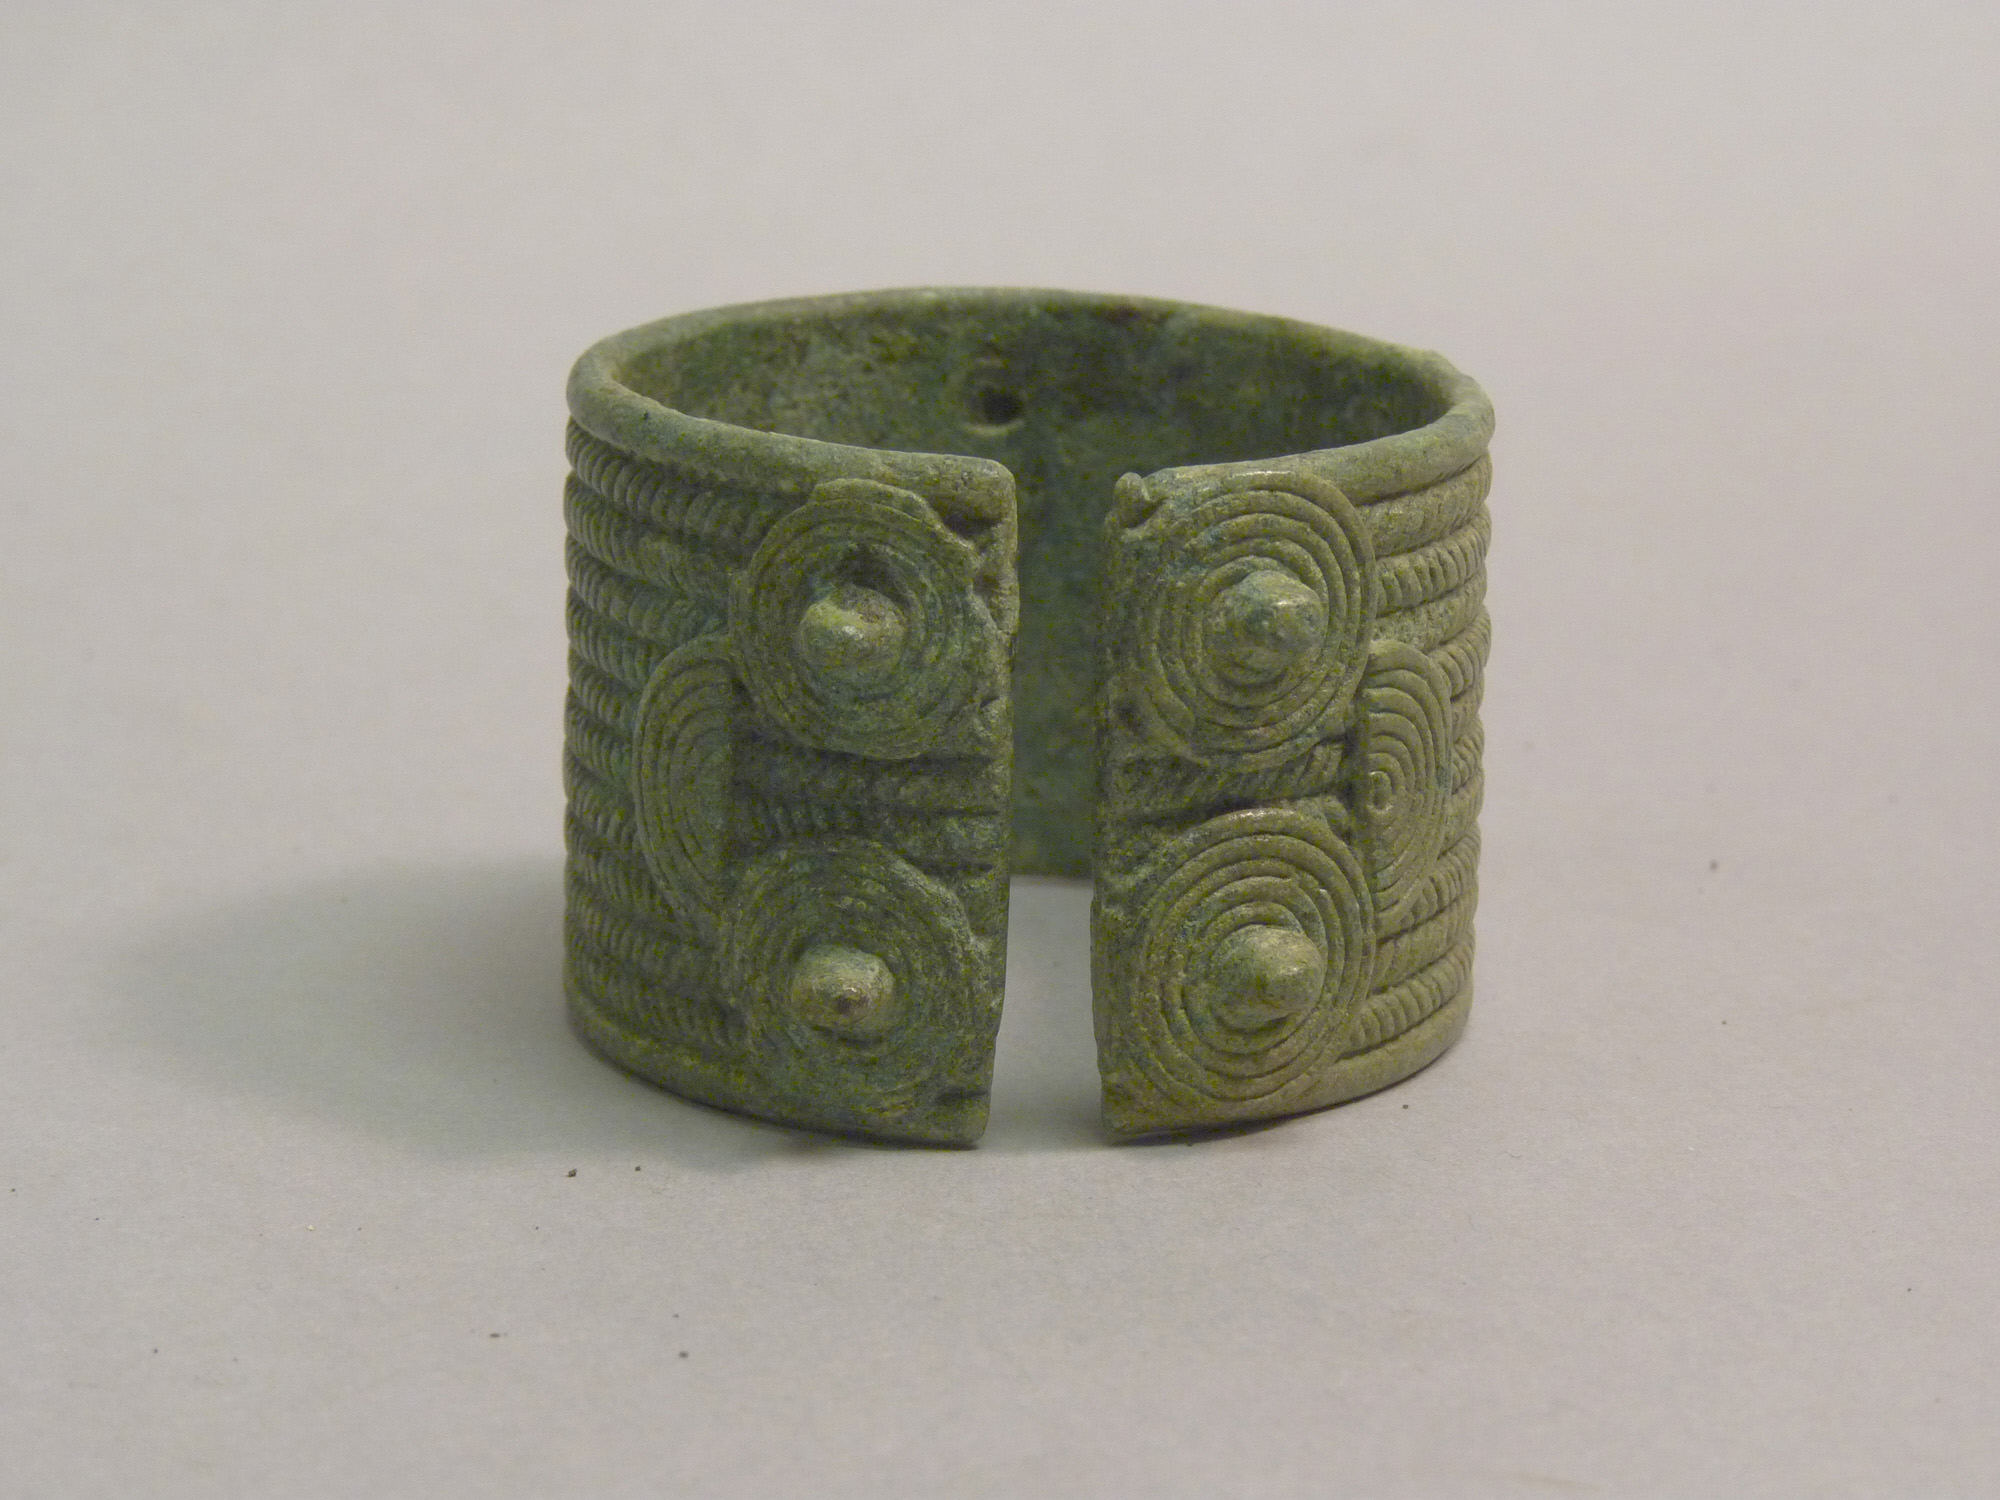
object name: bracelet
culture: thai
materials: bronze